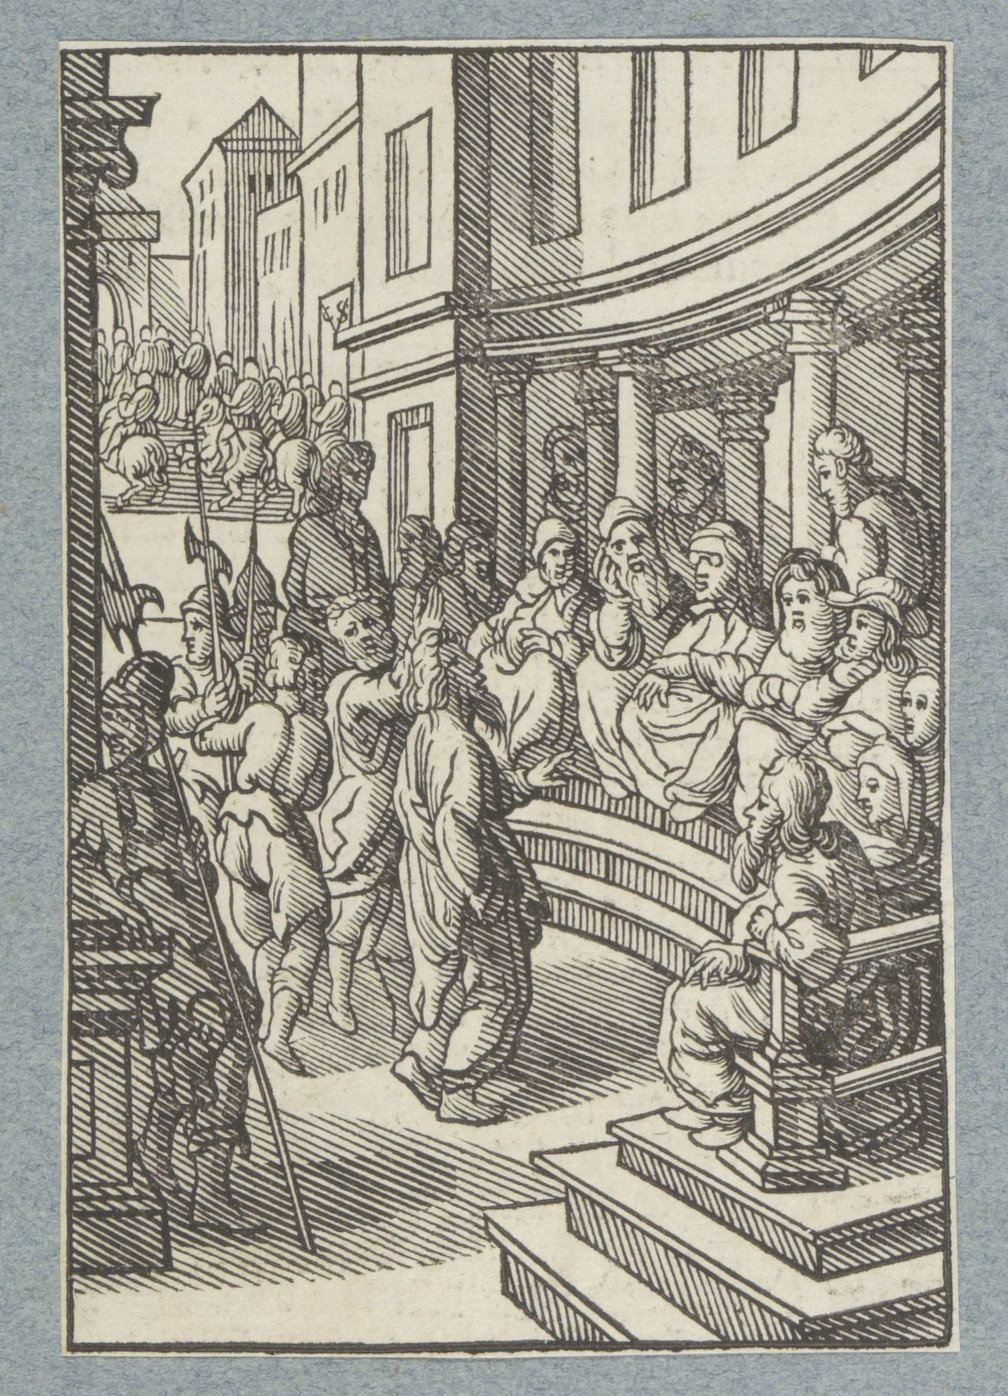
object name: album leaf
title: Paulus voor het Sanhedrin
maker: pieter jacobsz. paets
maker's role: publisher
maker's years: 1587-1667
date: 1629-1646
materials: paper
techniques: letterpress printing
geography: antwerp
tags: paul before the high priest ananias and the sanhedrin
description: De prent is afkomstig uit een van de uitgaven van P.J. Paets uit Amsterdam. De prent wordt mogelijk al gebruikt in: Der Zielen Lust-hof. Leuven, I.Jacbosz voor P.J. Paets [= Amsterdam, P.J. Paets], 1629. Ze komt in ieder geval voor in: Het Nieuwe Testament ons Salichmaeckers Jesu Christi. Amsterdam, P.J. Paets, 1646. De voorstelling is gekopieerd naar een prent van Philips Galle naar Jan van der Straet, onderdeel van de serie getiteld Acta Apostolorum.